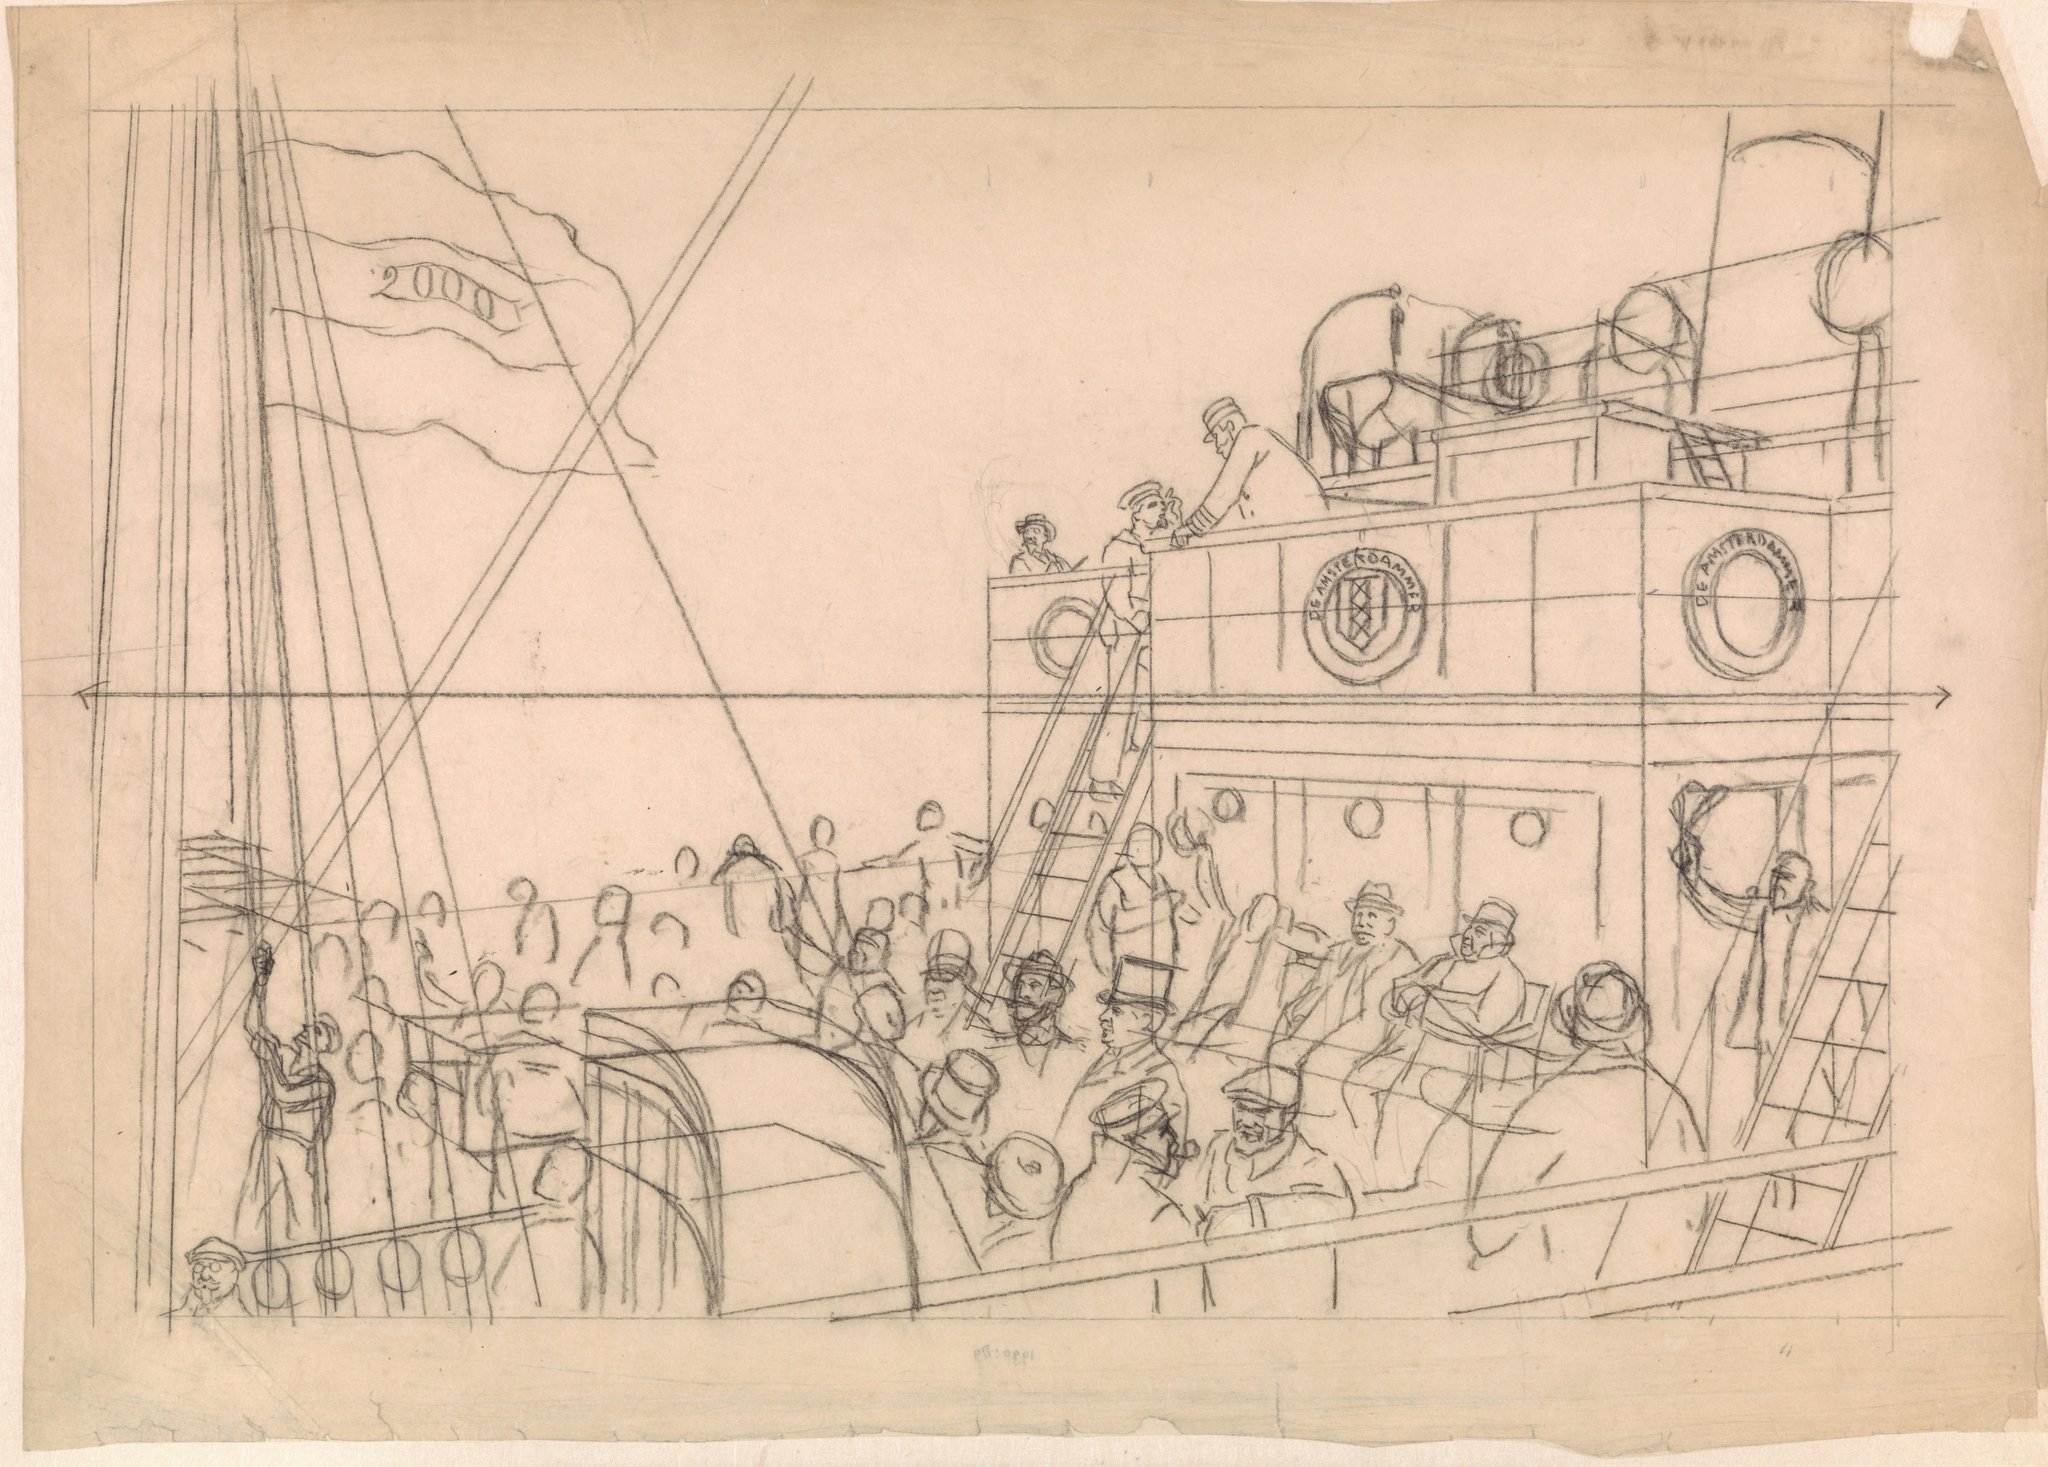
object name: design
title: Ontwerp voor illustratie in De Amsterdammer: Het 2000ste nummer. Aan boord van De Amsterdammer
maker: johan braakensiek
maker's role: draughtsman, print maker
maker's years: 1858-1940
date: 1915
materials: chalk, paper